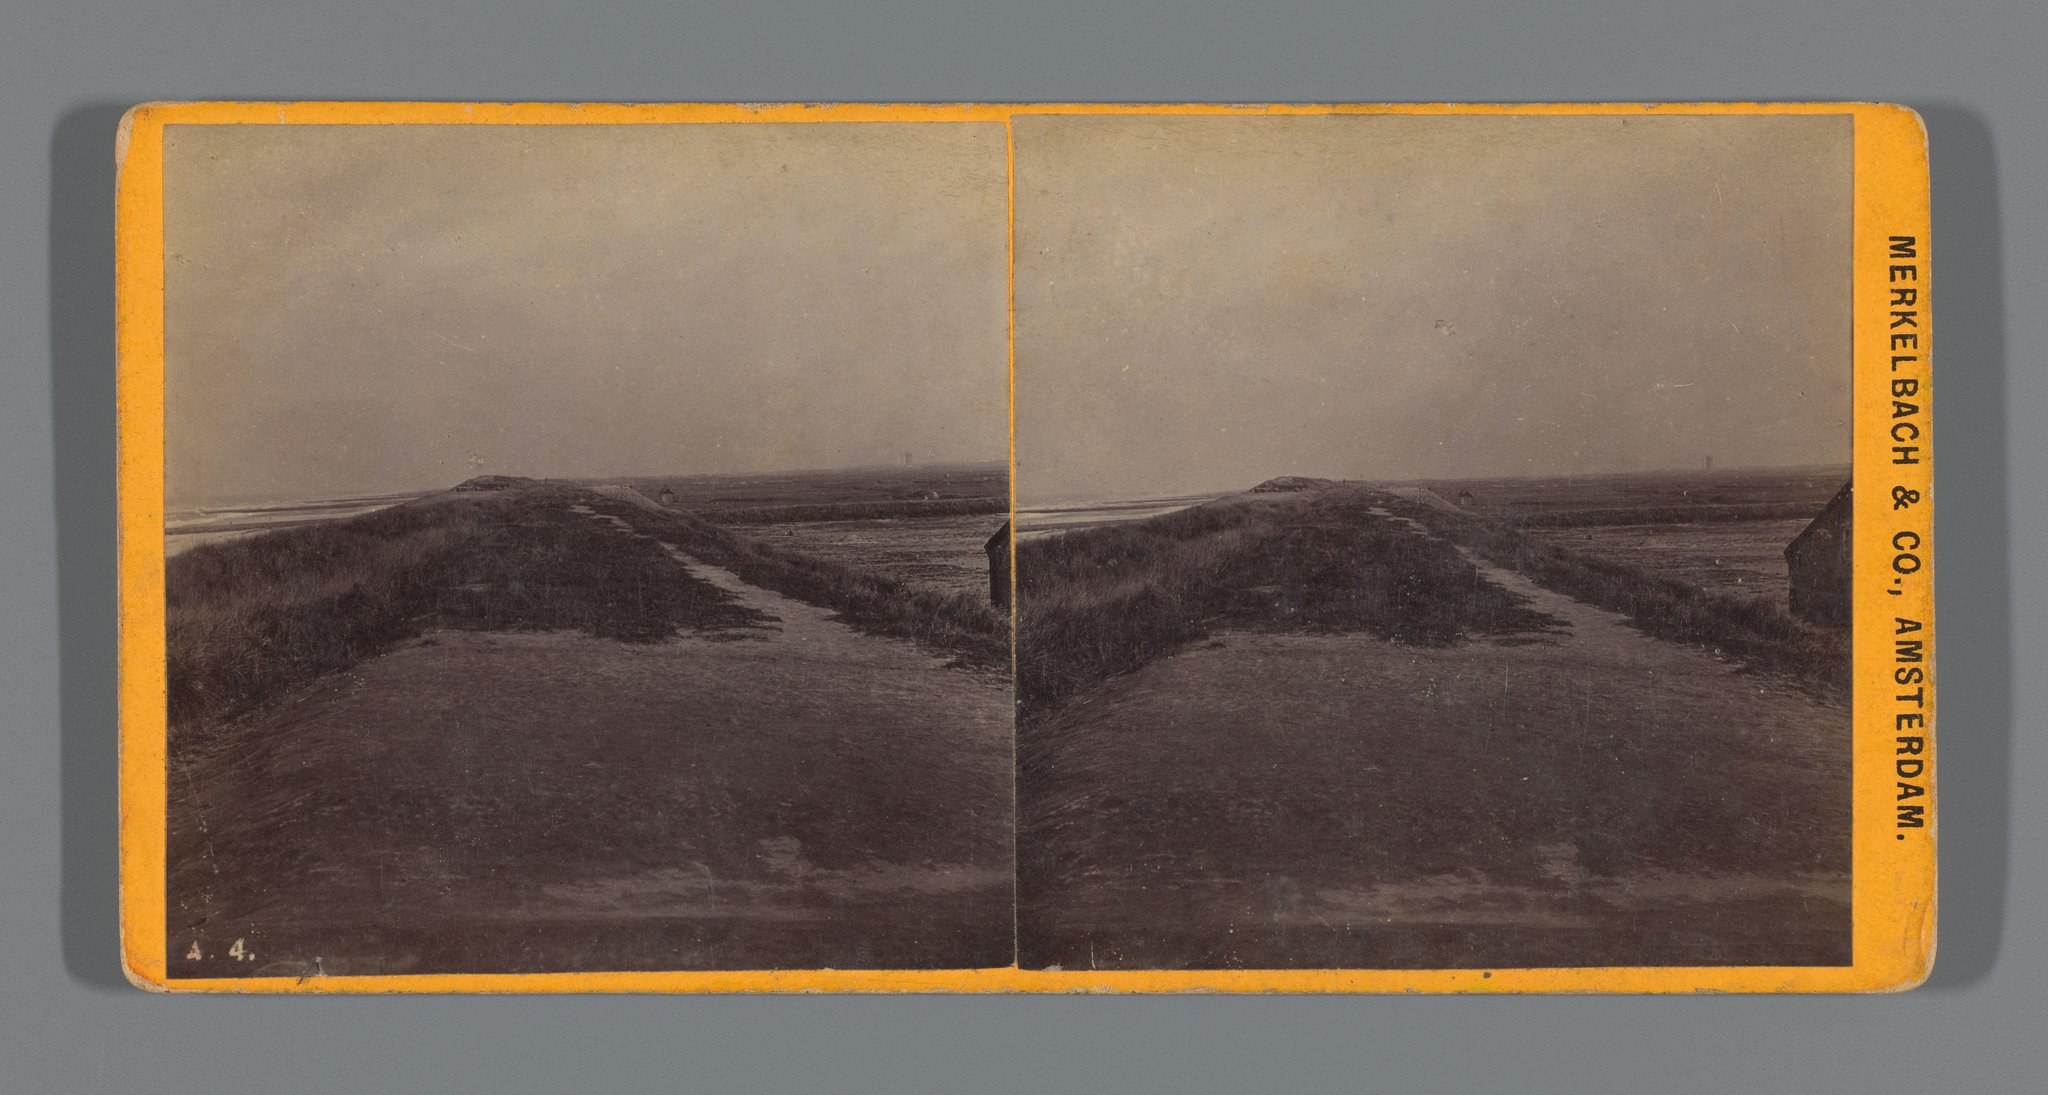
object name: stereograph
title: Aardrijkskundige Beeldengalerij, verzameld door M.J. Broekhuijsen, Hoofd eener school te Amsterdam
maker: martien johan broekhuijsen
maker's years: 1871-1956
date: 1905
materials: photographic support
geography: amsterdam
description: Onderdeel van een groep van 52 stereofoto's gebruikt in het lager onderwijs als aanvulling op schoolplaten. De gehele reeks bestond uit 274 nummers in 10 categorieën (A t/m K).